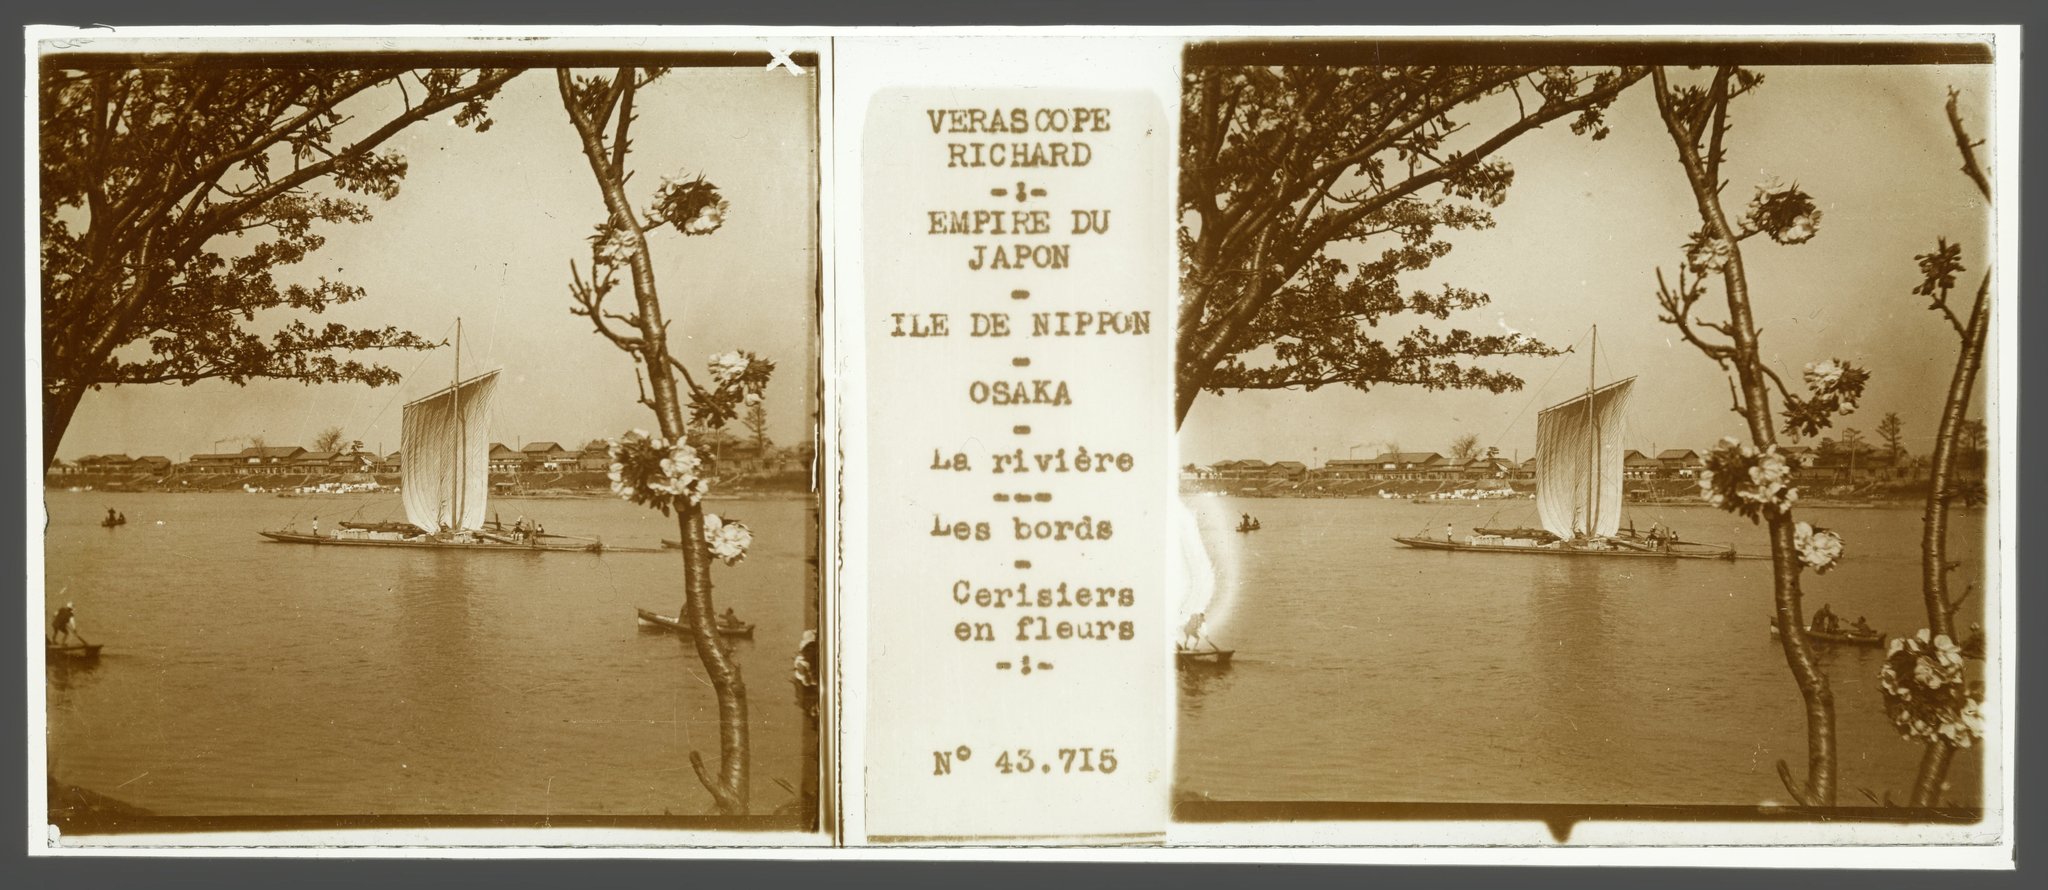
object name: stereoscopic photograph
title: Kersenbloesems en een zeilschip op de rivier de Yodo te Osaka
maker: Anonymous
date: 1893-1920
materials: glass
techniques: gelatin silver transparency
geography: osaka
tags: sailing-ship, sailing-boat, trees: cherry-tree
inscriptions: number: ‘No 43.715’